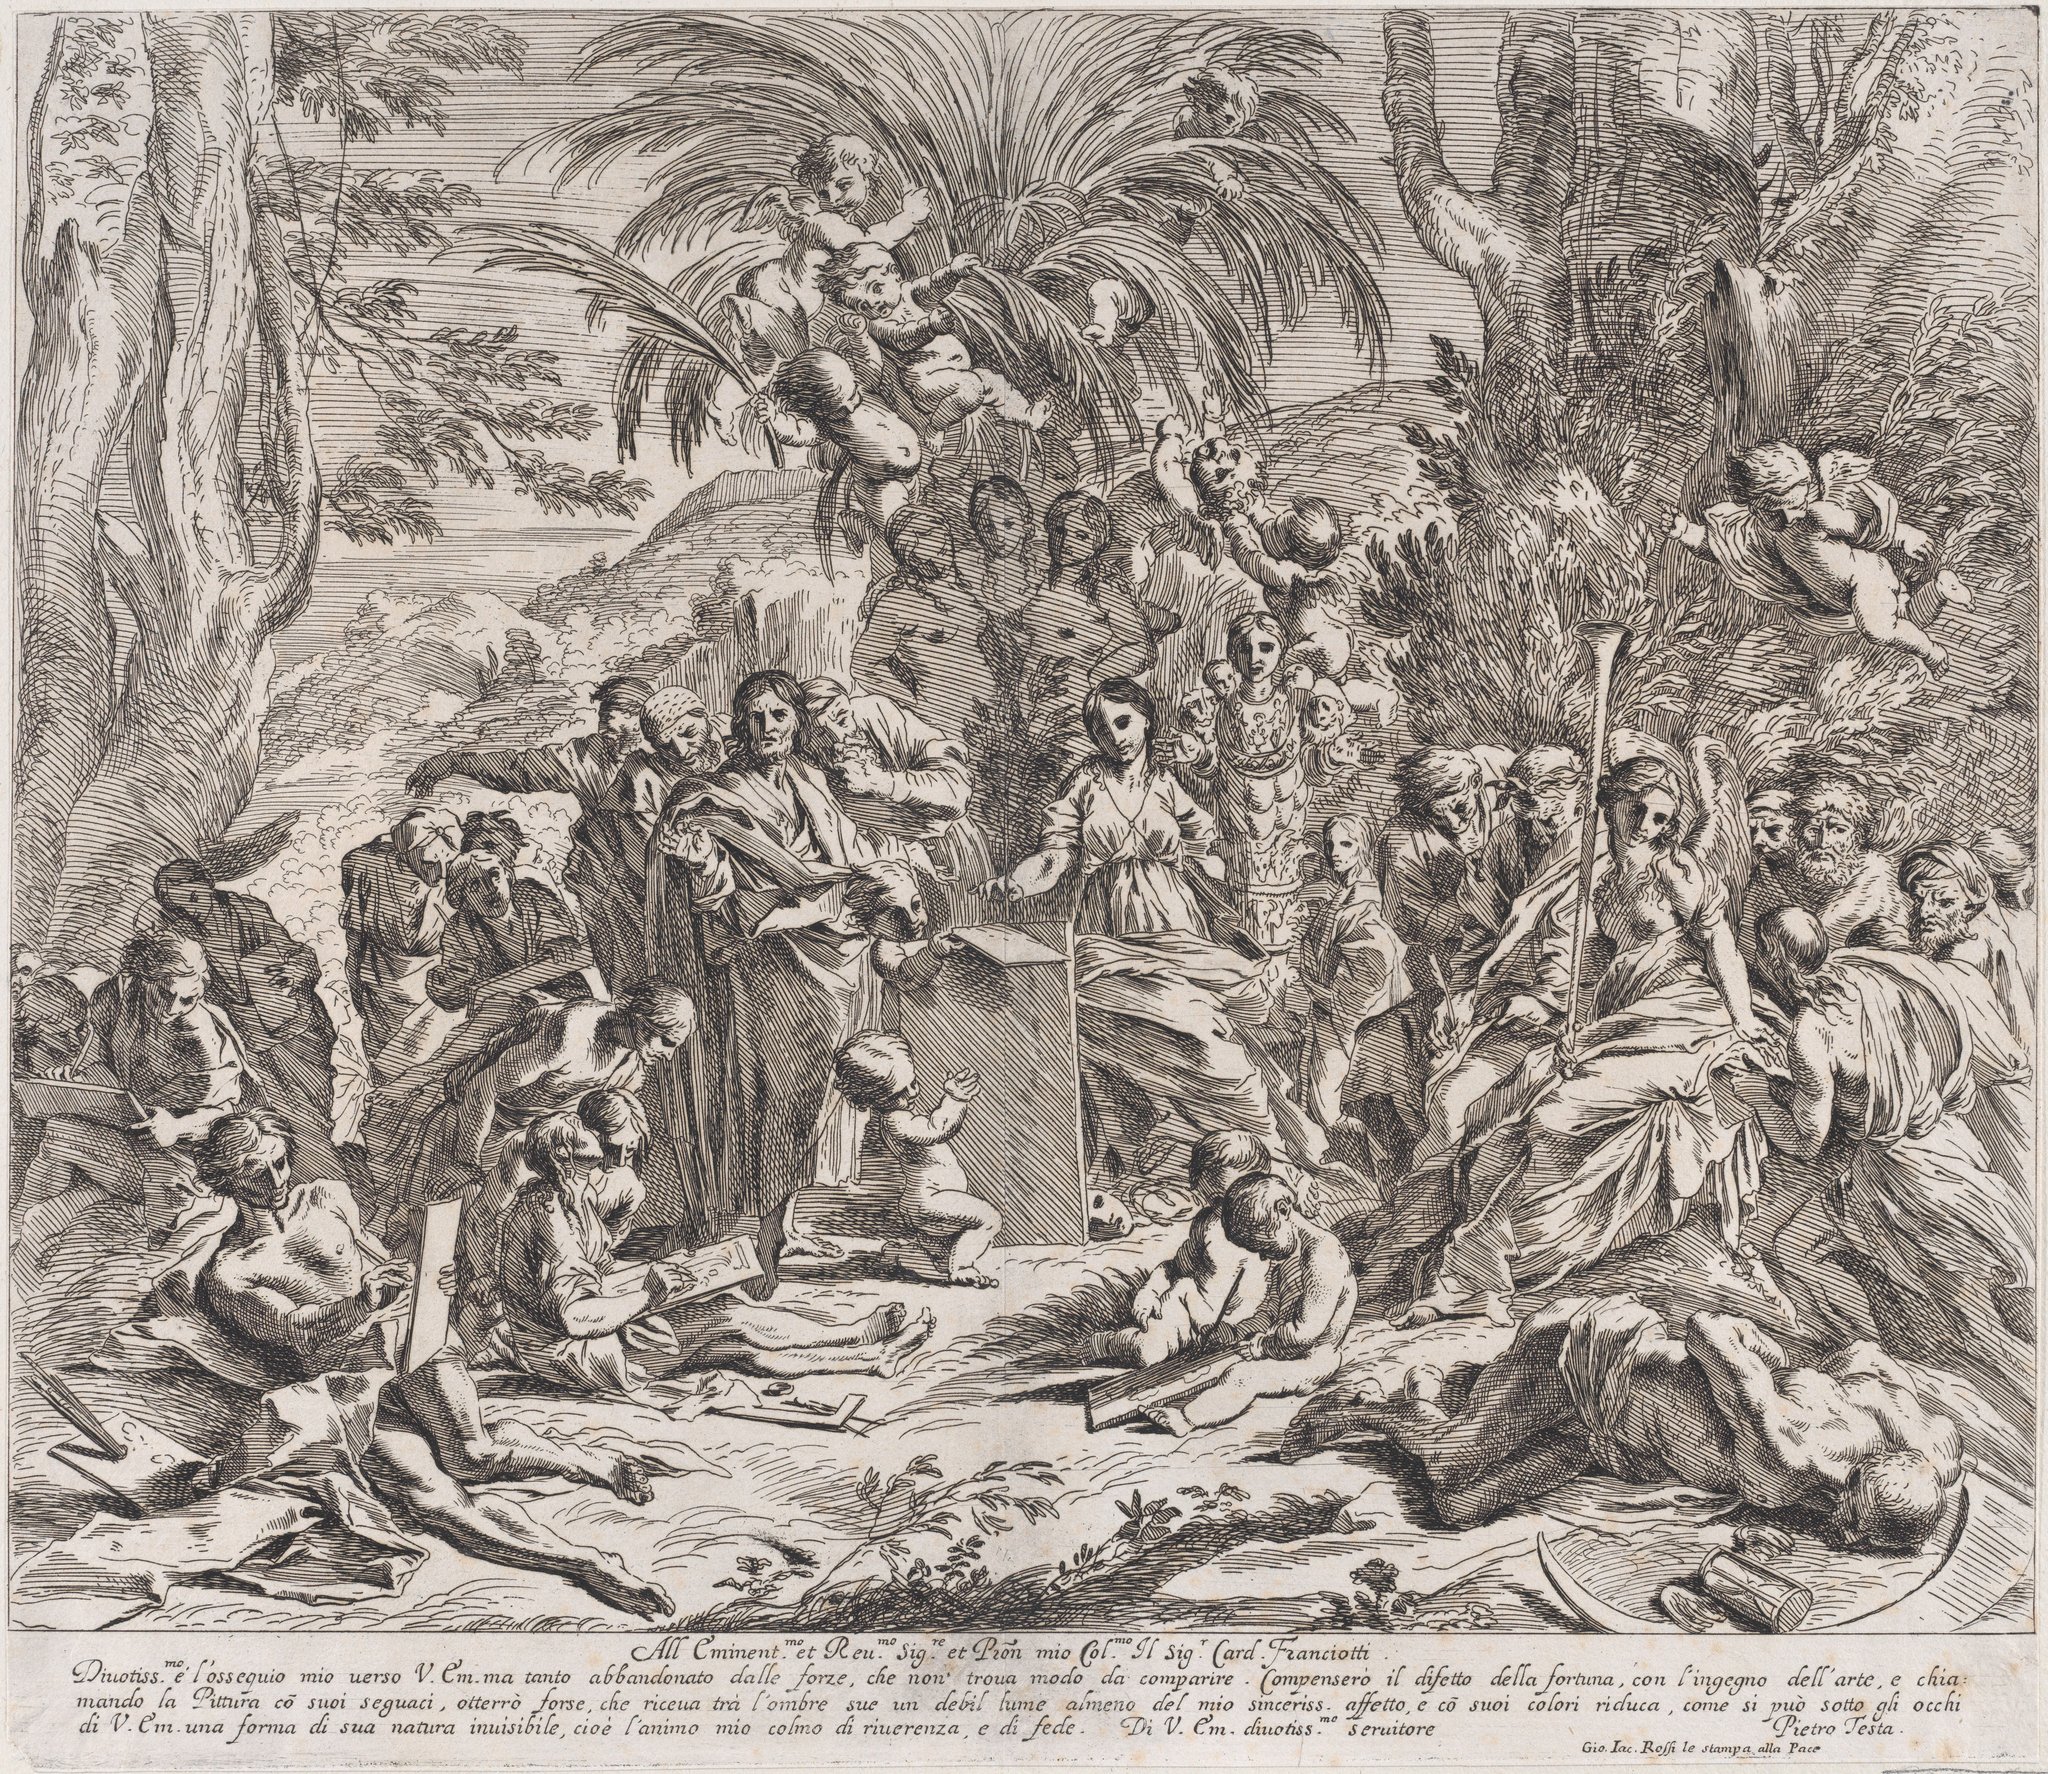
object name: print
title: An allegory of painting, who as a child in the centre left draws on a tablet, surrounded by figures, many of whom are drawing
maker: pietro testa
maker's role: artist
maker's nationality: italian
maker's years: 1612-1650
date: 1637-1638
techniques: etching